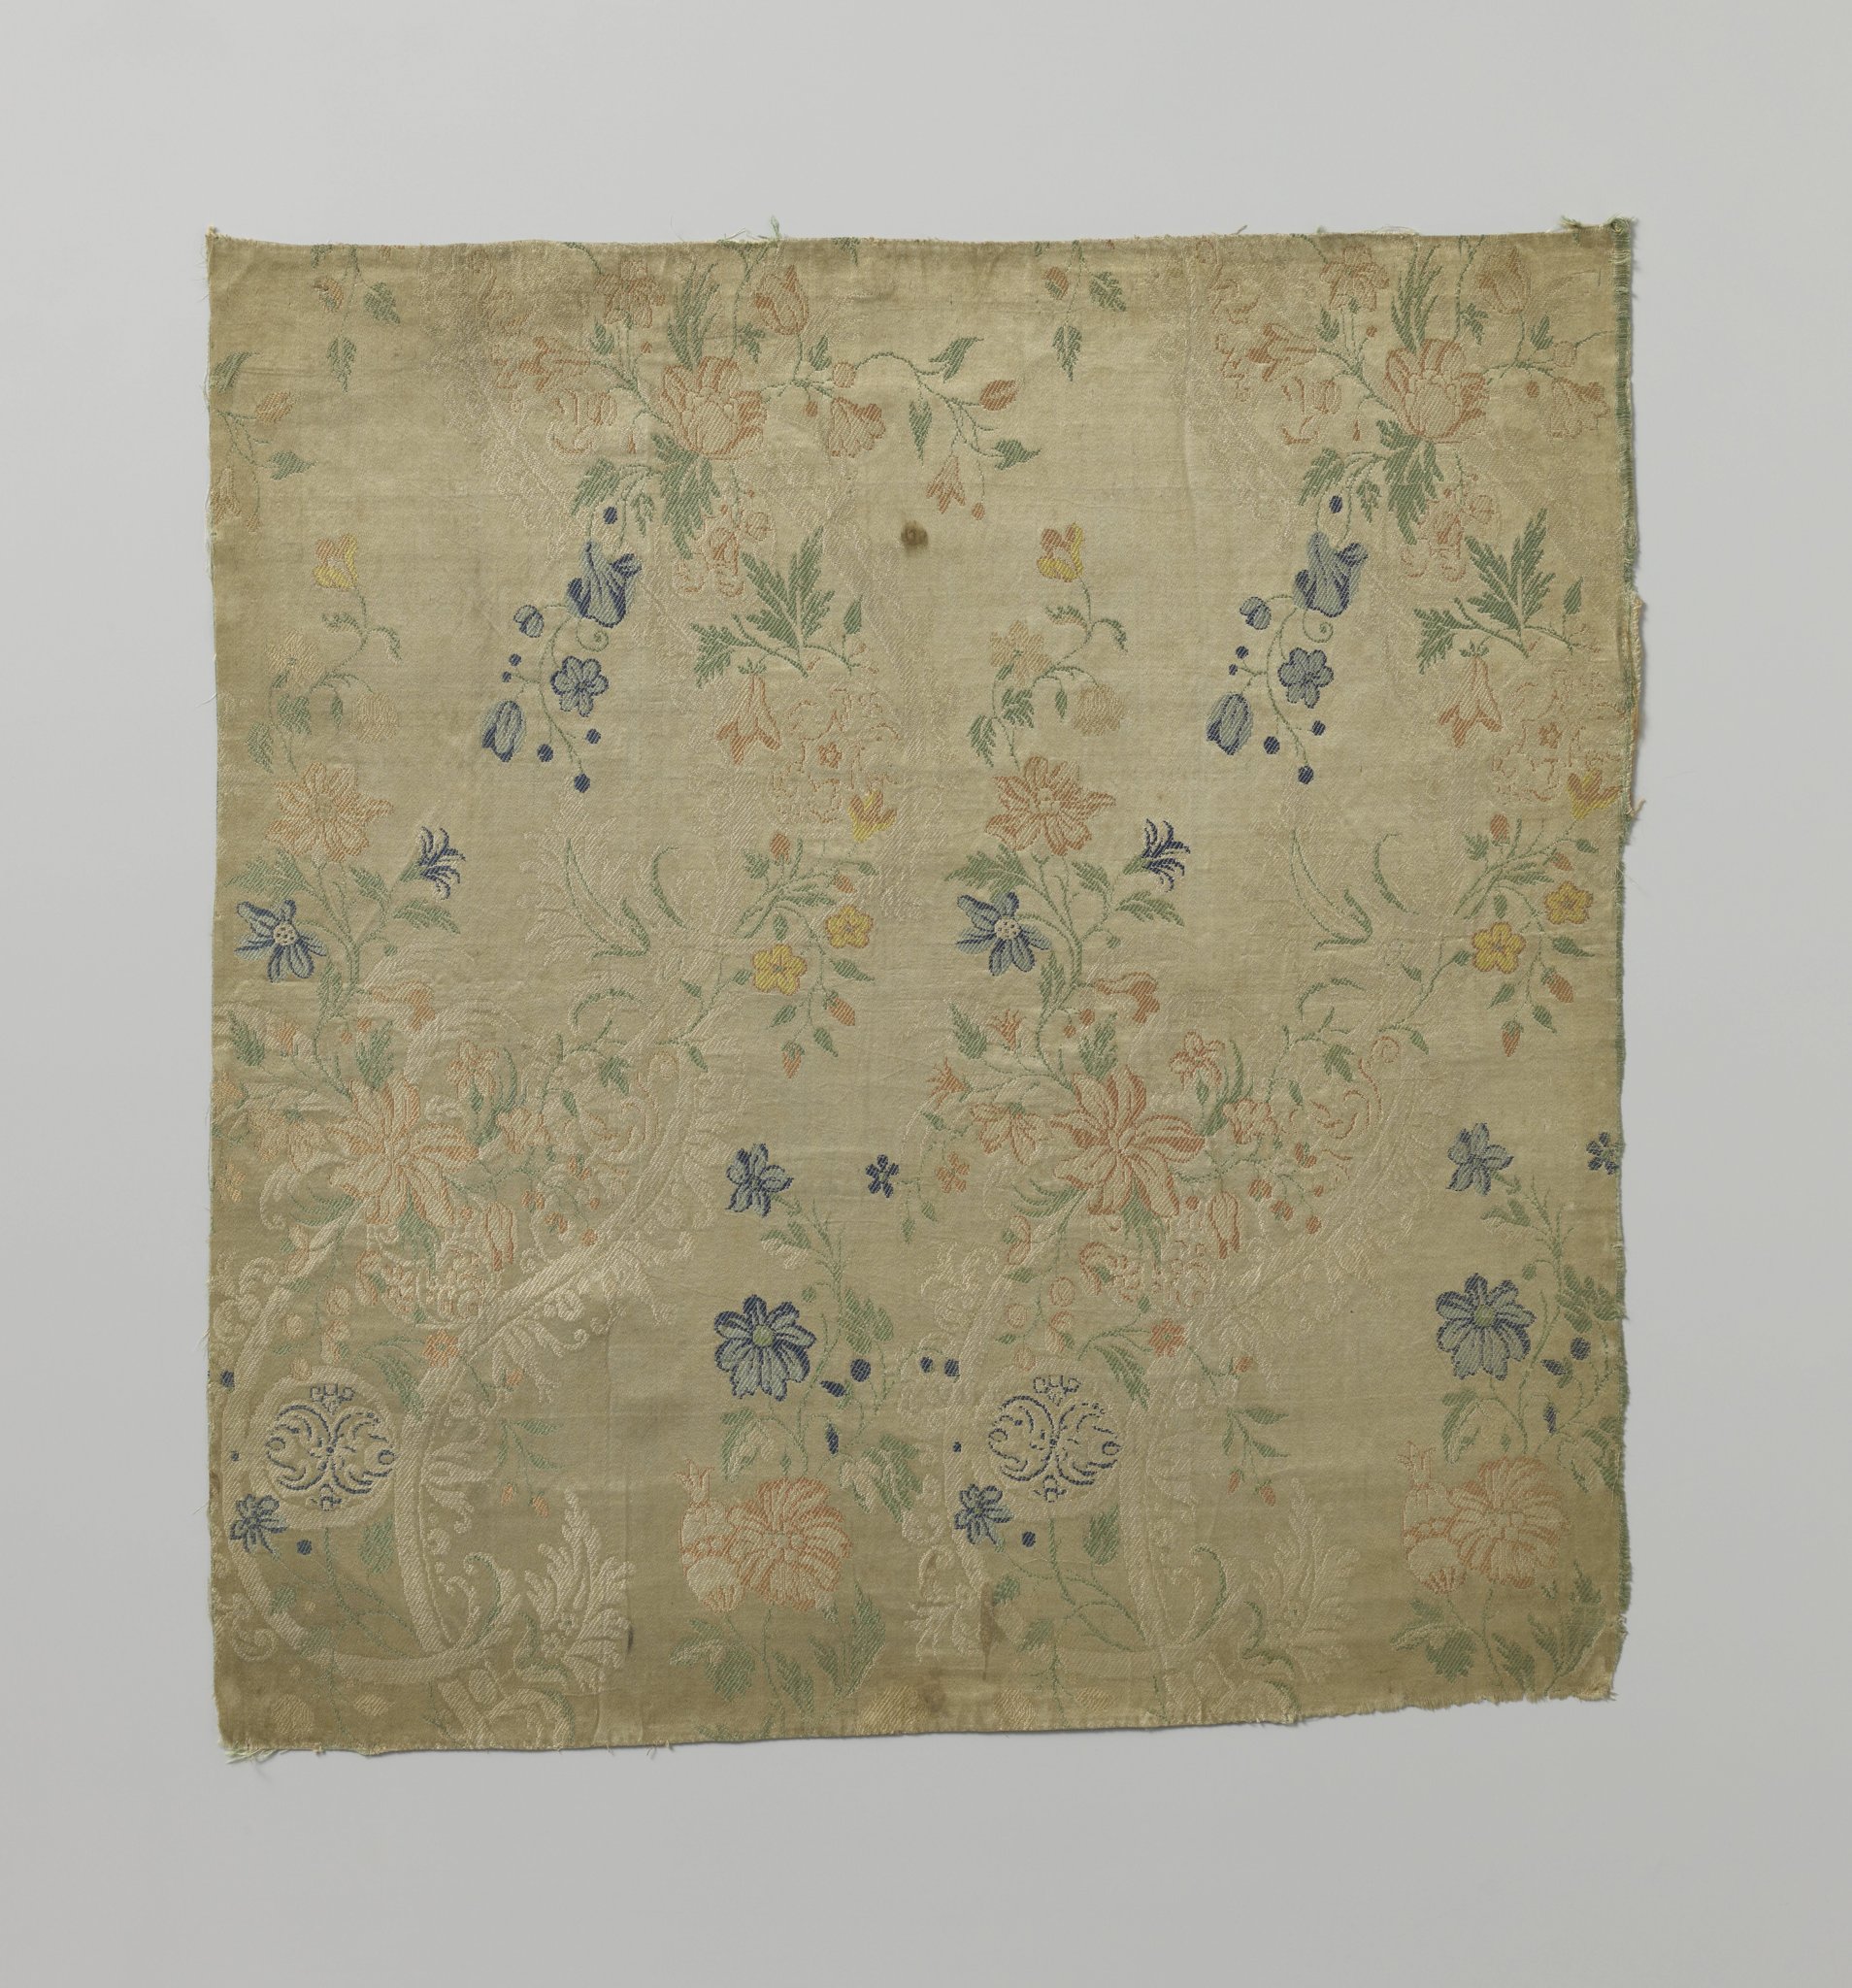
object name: fragment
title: Fragment veelkleurige zijde met op een wit fond (bruin verkleurd?) een patroon van krulwerk en gestileerde bladmotieven met in en op de geslingerde banen bloemen en bloemtakken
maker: Anonymous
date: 1700-1725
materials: silk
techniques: brocade, weave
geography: france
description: Fragment veelkleurig zijdeweefsel met op een wit fond (bruin verkleurd?) een patroon van slingerende banen bestaande uit wit krulwerk en gestileerde bladmotieven. Op en tussen de slingerende banen heeft het patroon veelkleurige bloemen en bloemtakken.